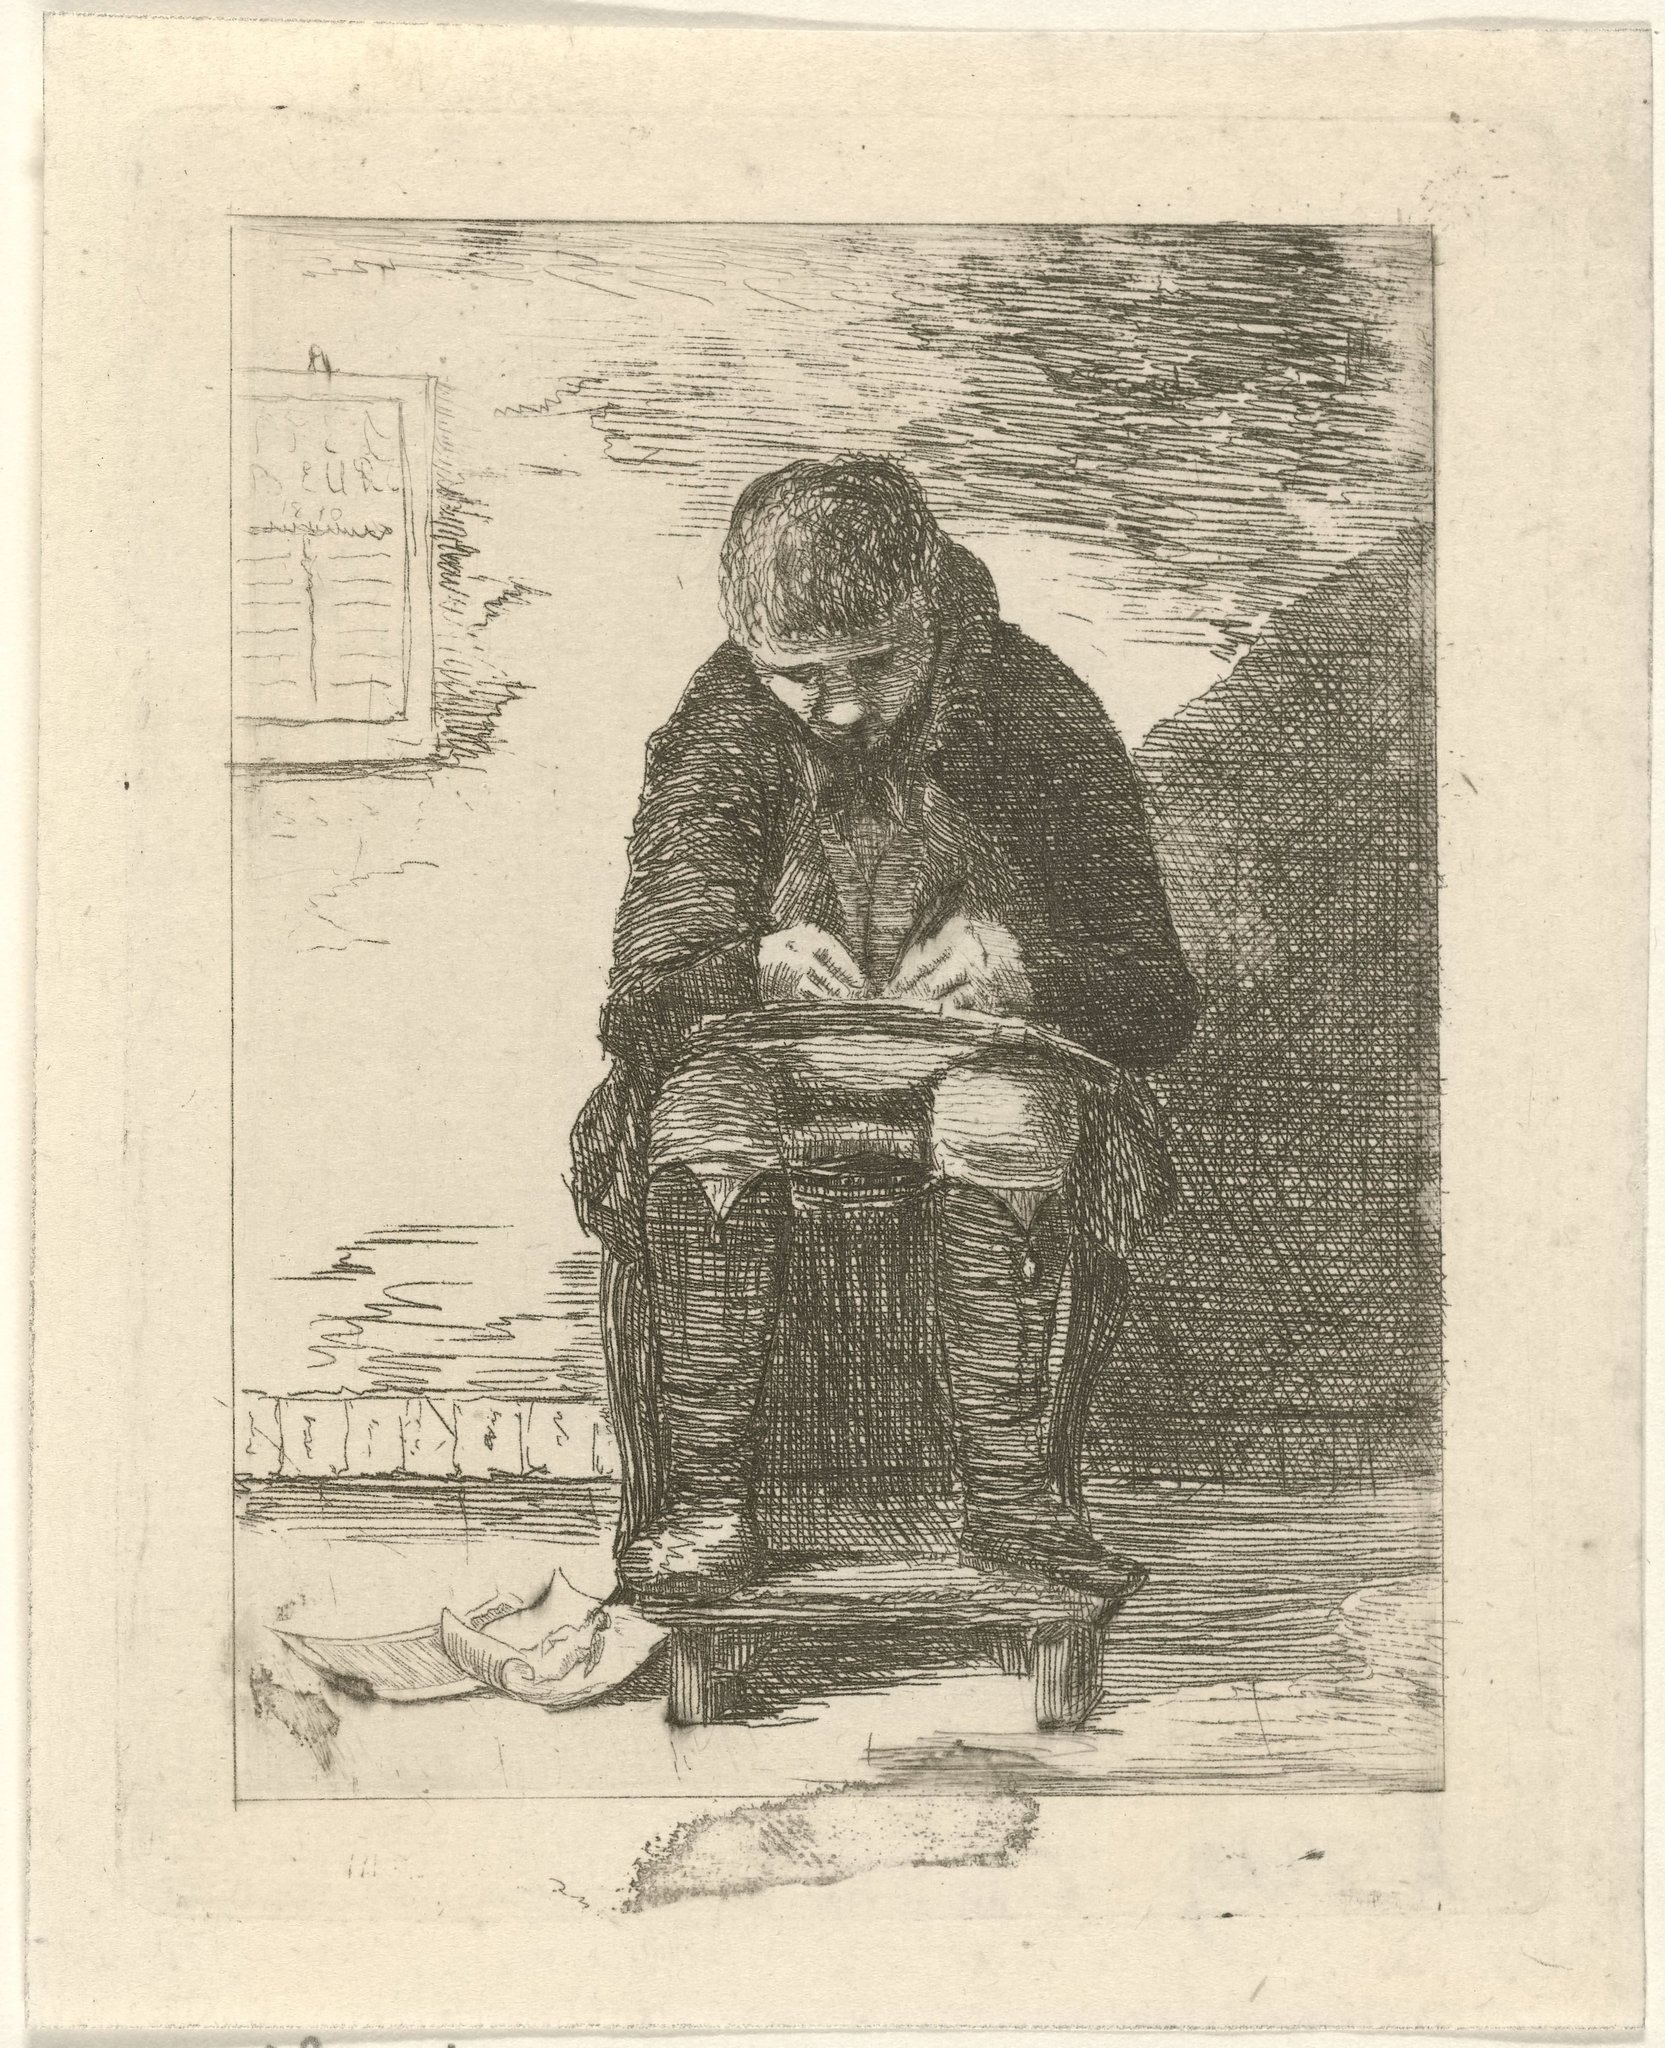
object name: print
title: Tekenaar in een interieur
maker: gerrit lamberts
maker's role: bookseller, draughtsman, print maker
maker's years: 1776-1850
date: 1810-1850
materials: paper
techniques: etching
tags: drawing, sketch, draughtsman at work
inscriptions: collector's mark: Lugt 2228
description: Een jongen zit met een tekenplank op schoot te tekenen, links liggen twee tekening op de grond. Aan de muur hangt een lijst met het opschrift: Steebeurs (?) 1810.